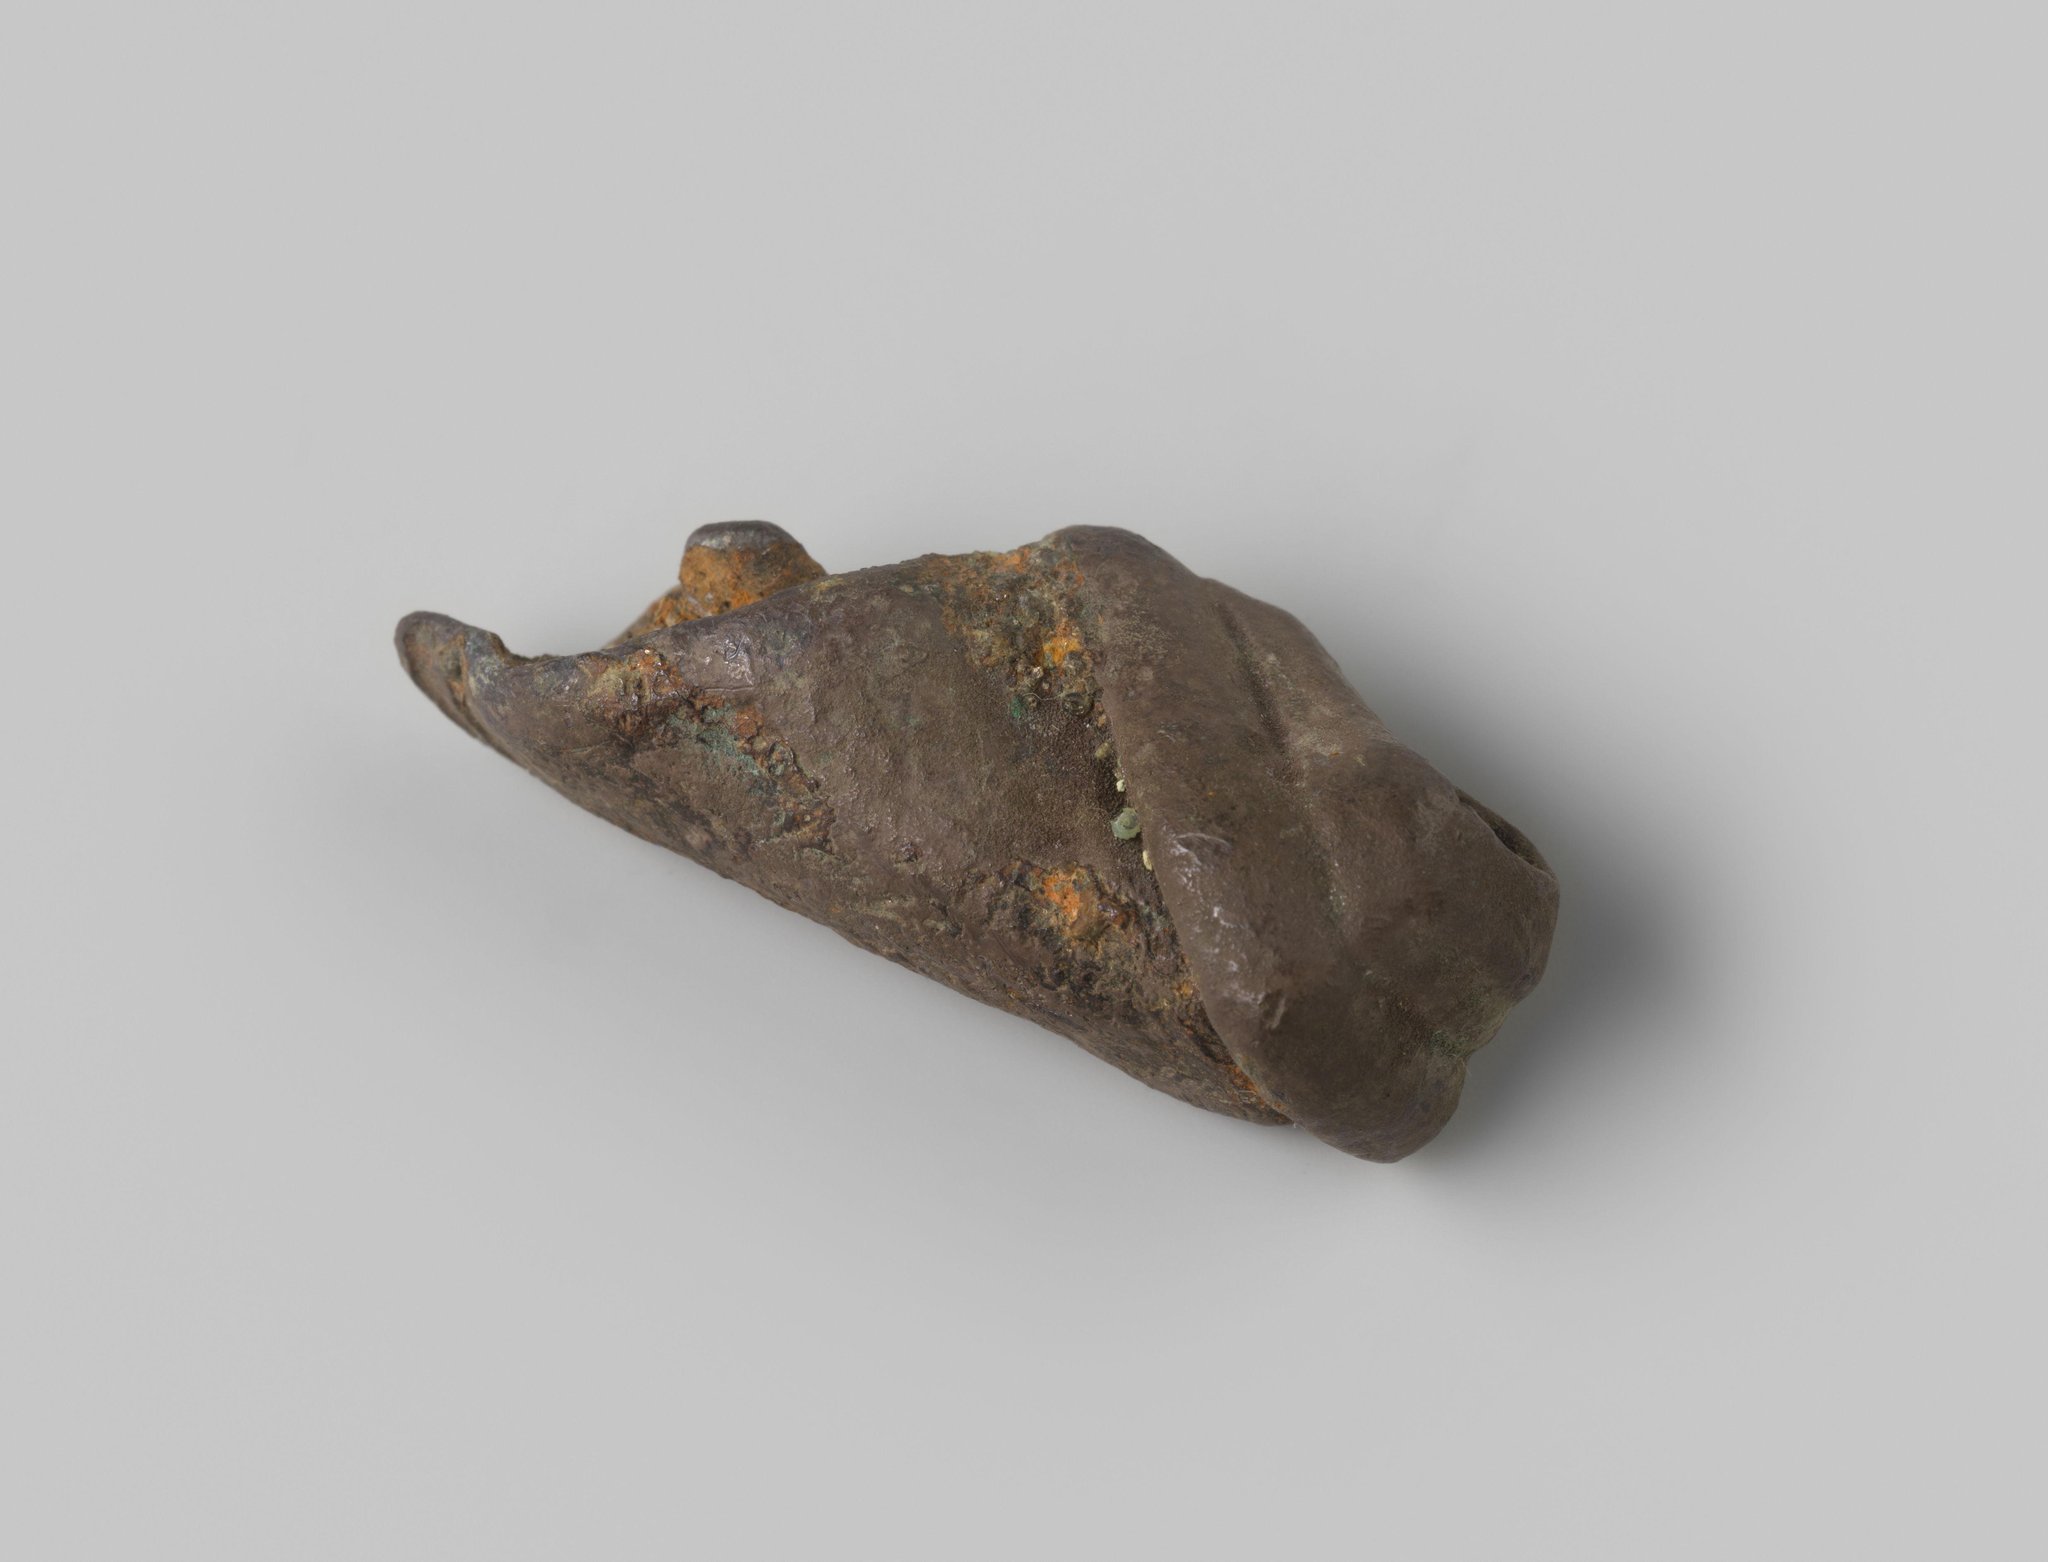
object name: candlestick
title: Fragment steel van een kandelaar uit het wrak van de Oost-Indiëvaarder Hollandia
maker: Anonymous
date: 1700-1743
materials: silver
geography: netherlands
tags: verenigde oostindische compagnie, hollandia (schip), annet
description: Candlestick, stem; fragm of moulded rim, sim. NG 1980-27H2988.